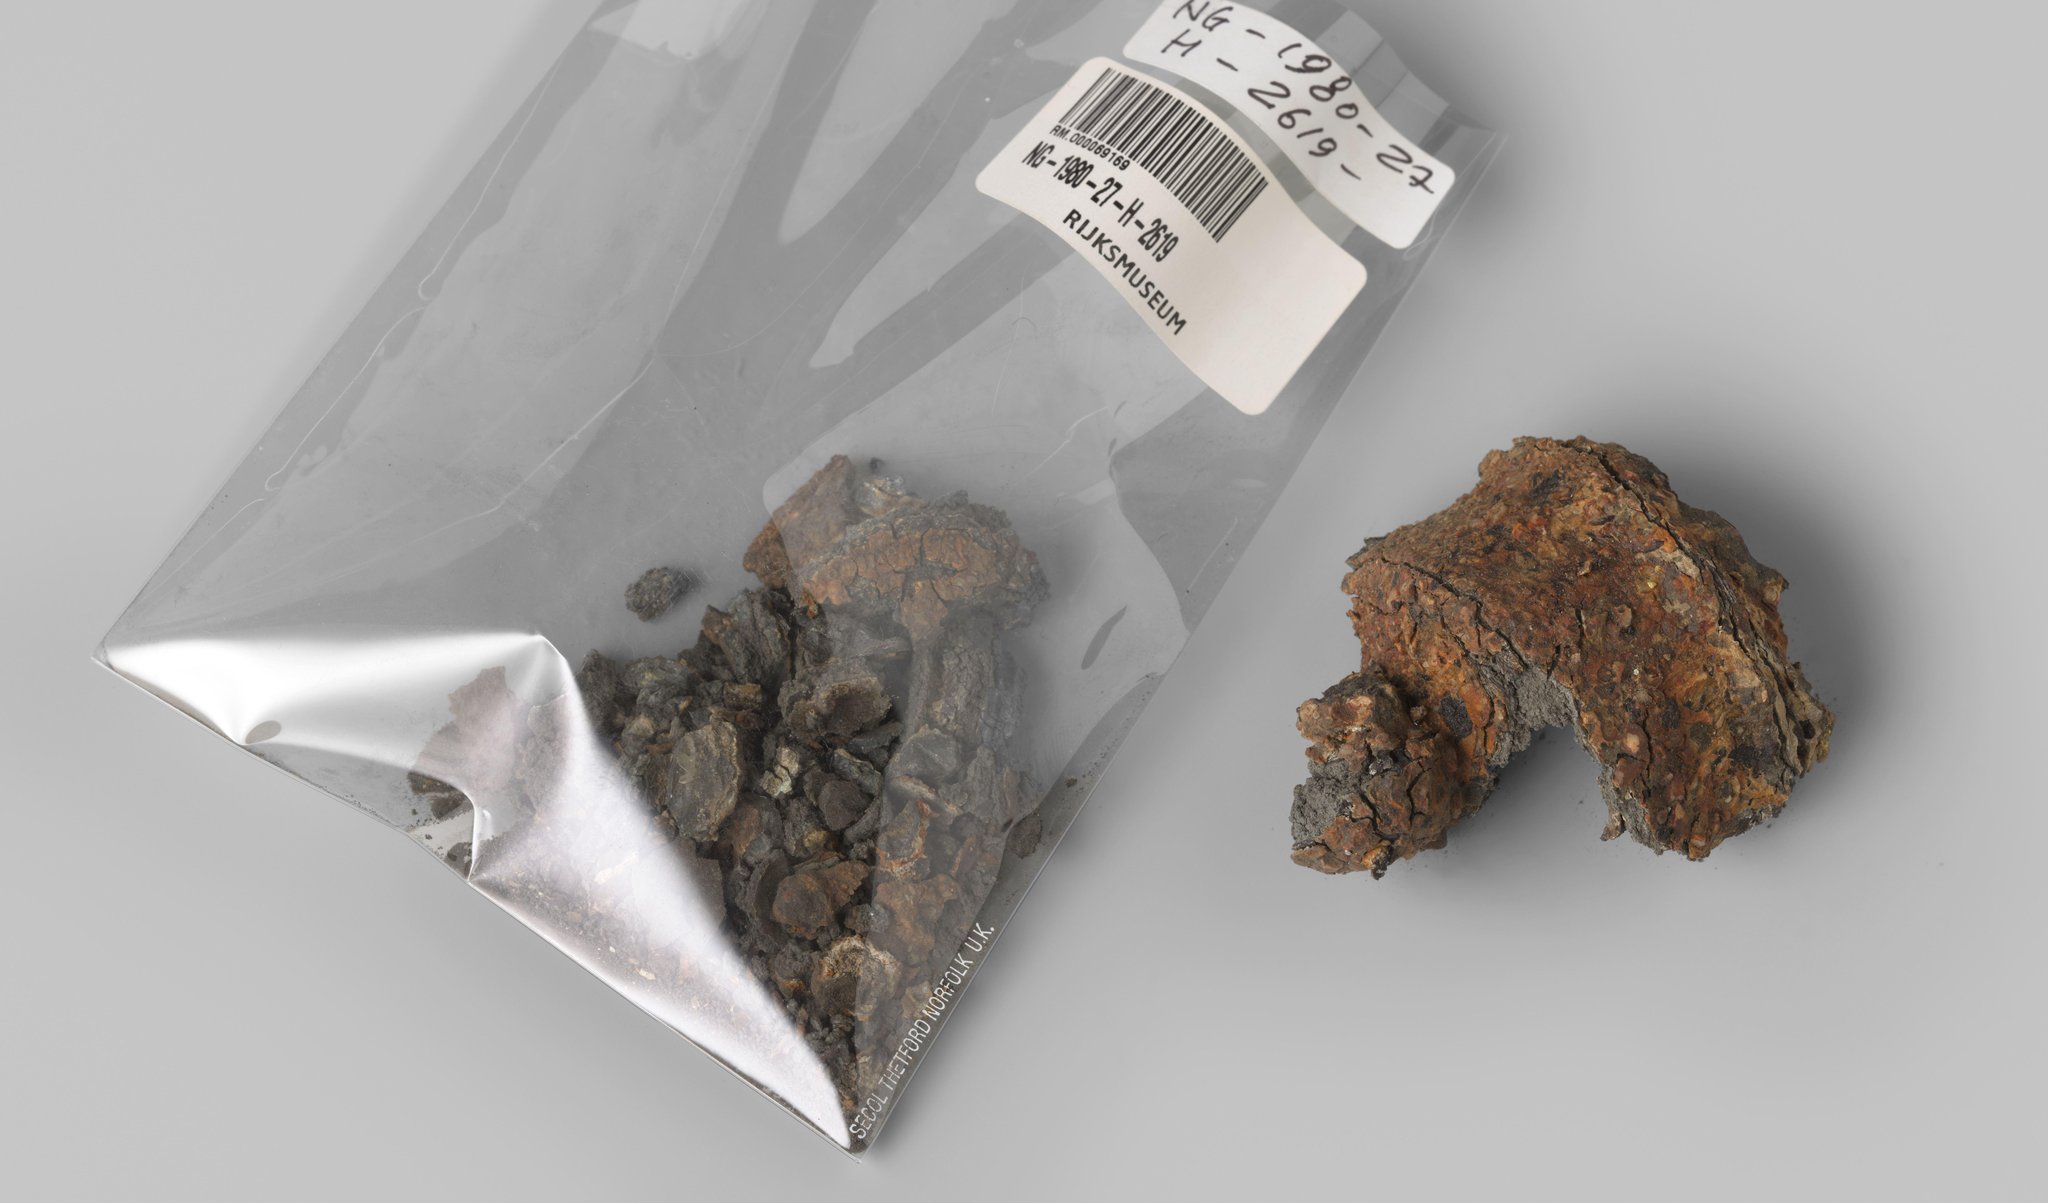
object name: screwcap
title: Schroefdop uit het wrak van de Oost-Indiëvaarder Hollandia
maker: Anonymous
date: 1700-1743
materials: tin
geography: netherlands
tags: verenigde oostindische compagnie, hollandia (schip), annet